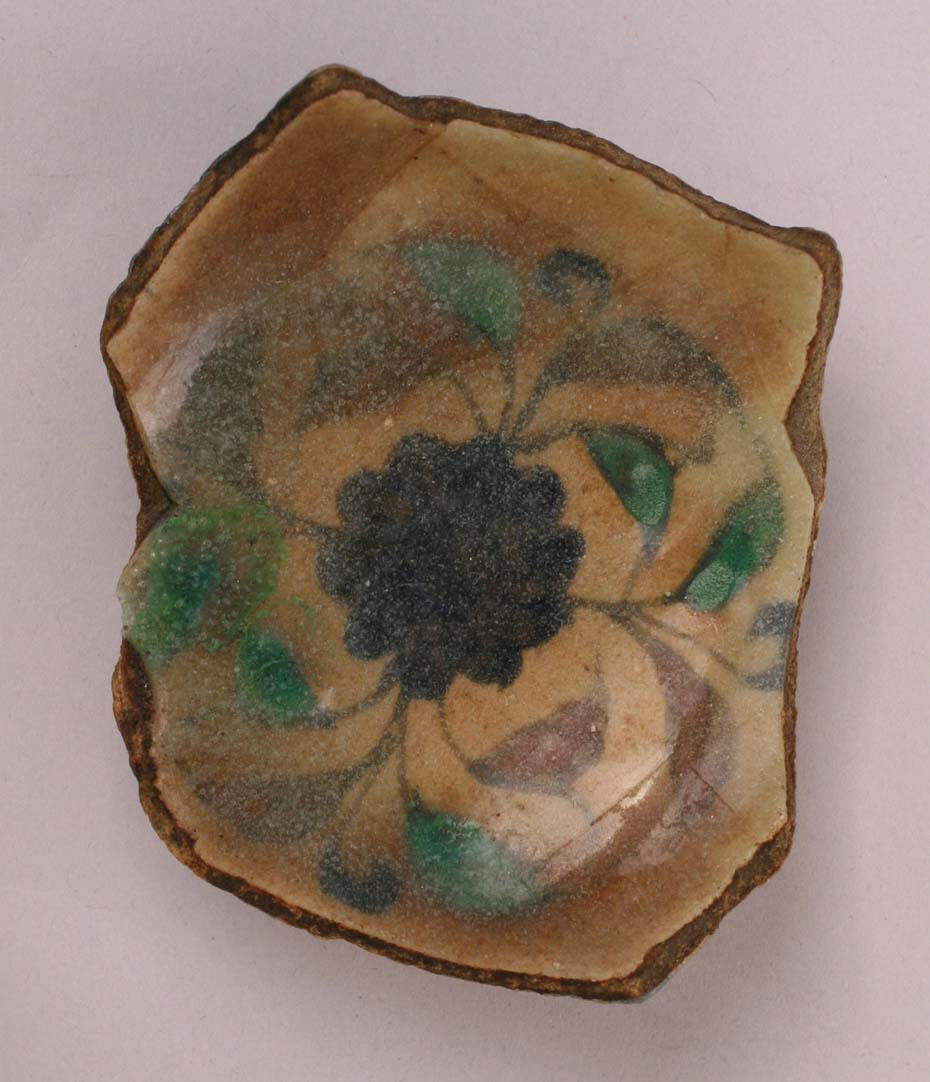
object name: fragment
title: Fragment of a Bowl or Cup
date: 1201-1600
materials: glaze, stonepaste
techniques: painting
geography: egypt